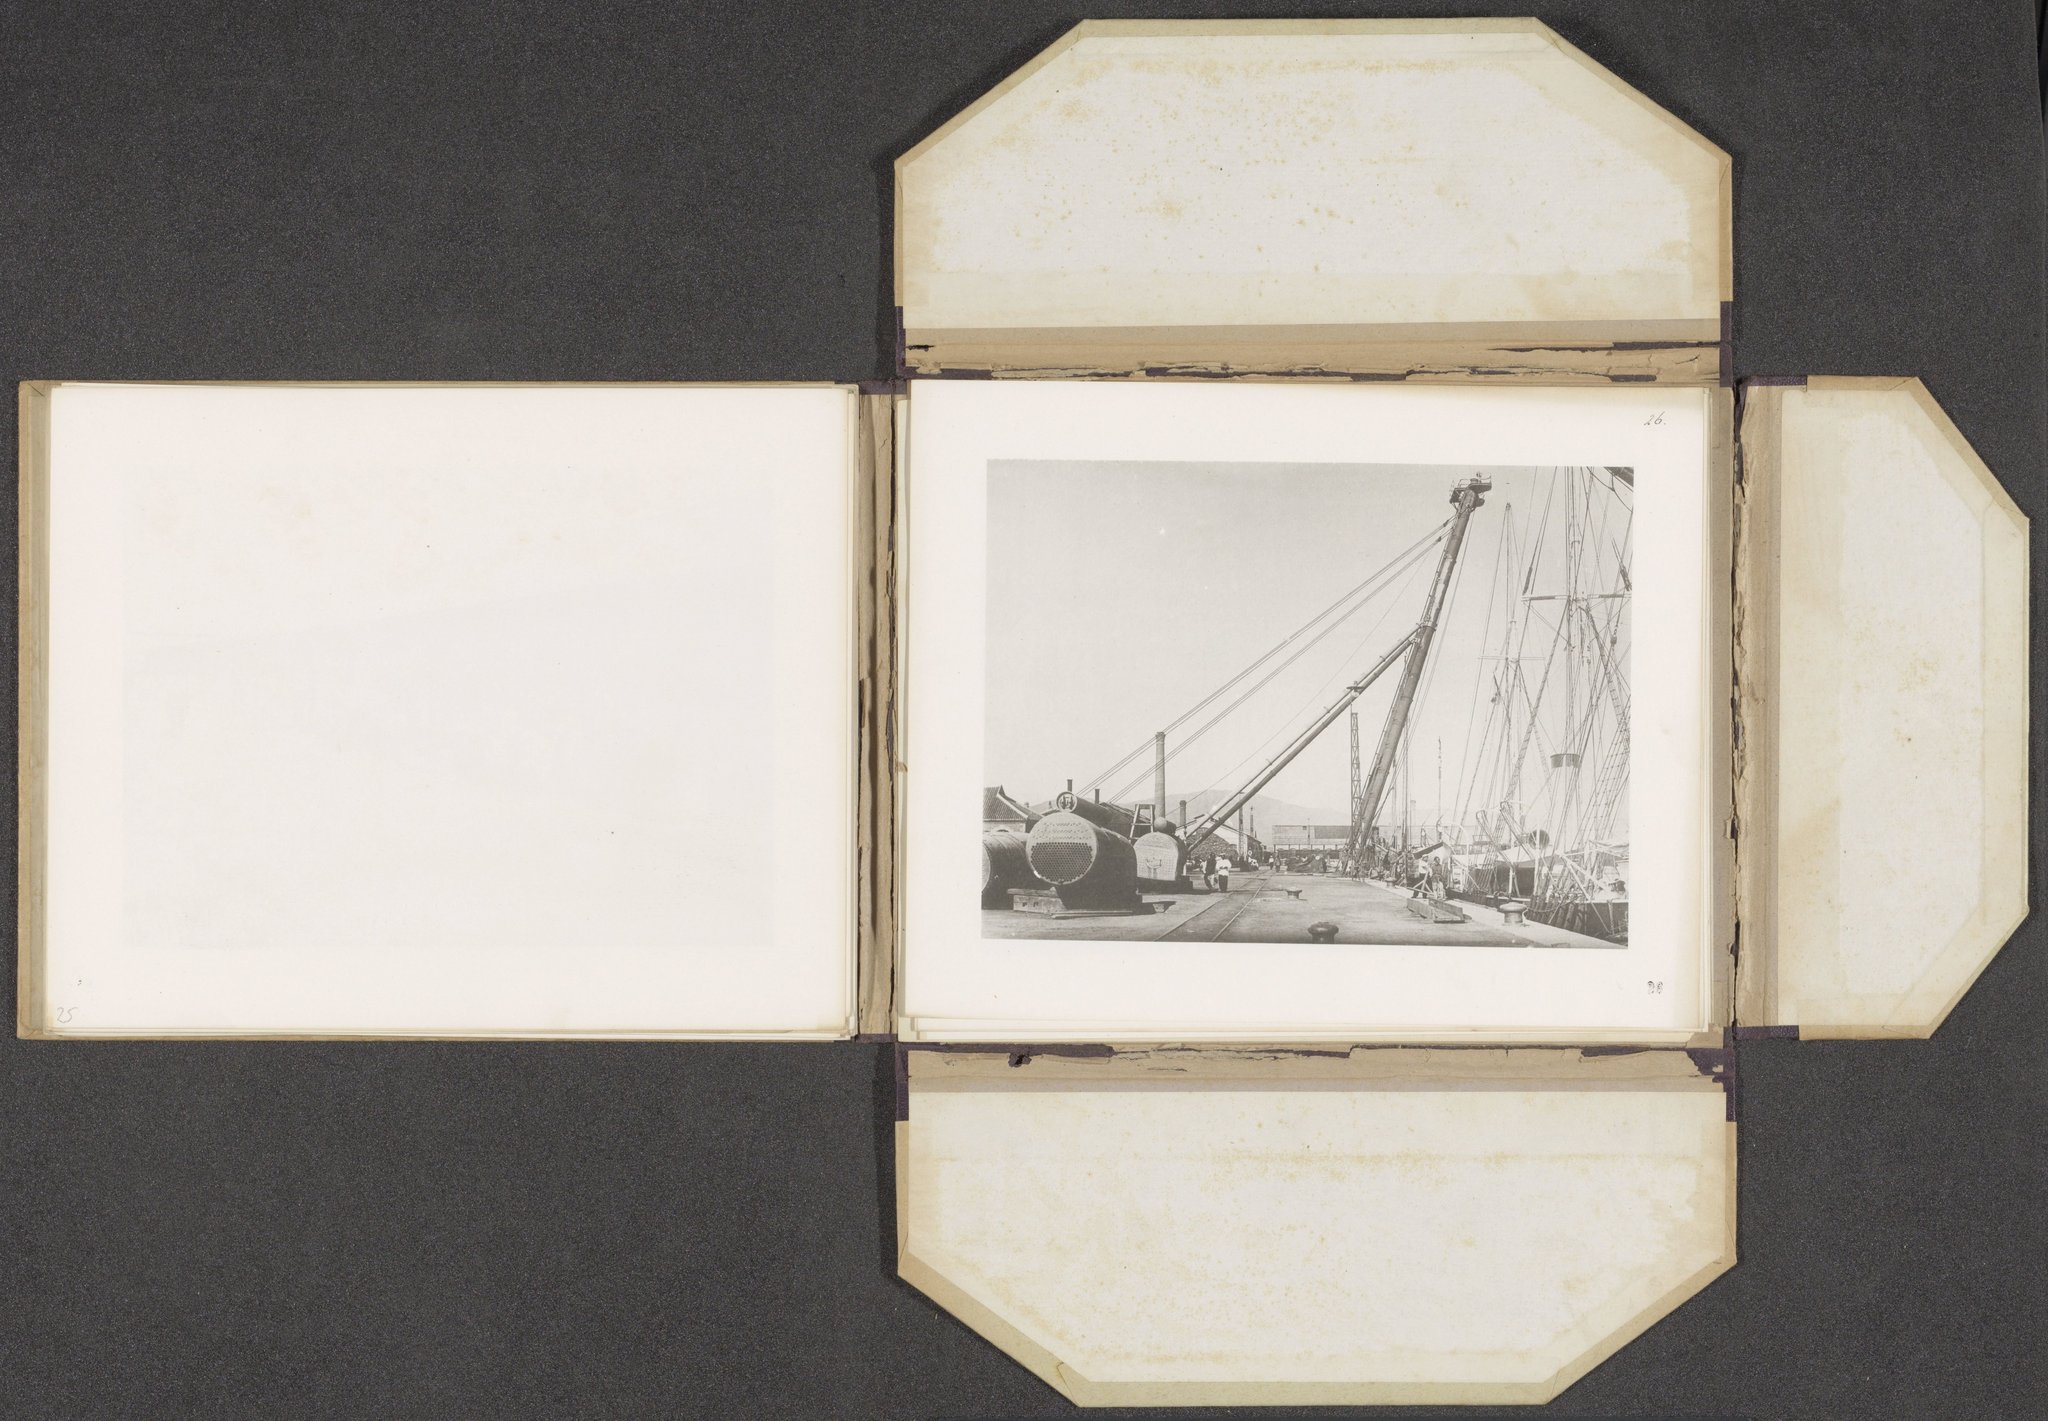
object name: page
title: Havenkraan te Port Arthur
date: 1898-1899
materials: paper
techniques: photograph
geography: port arthur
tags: harbour, dock crane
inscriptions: number: ‘26’